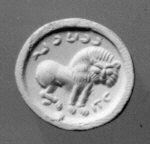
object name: stamp seal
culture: sasanian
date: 401-500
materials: gemstone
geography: iran or mesopotamia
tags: animals